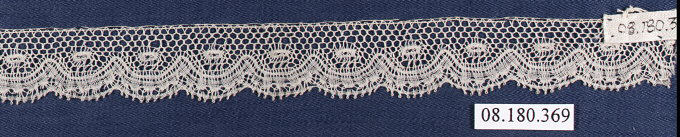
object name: piece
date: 1701-1800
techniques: lace